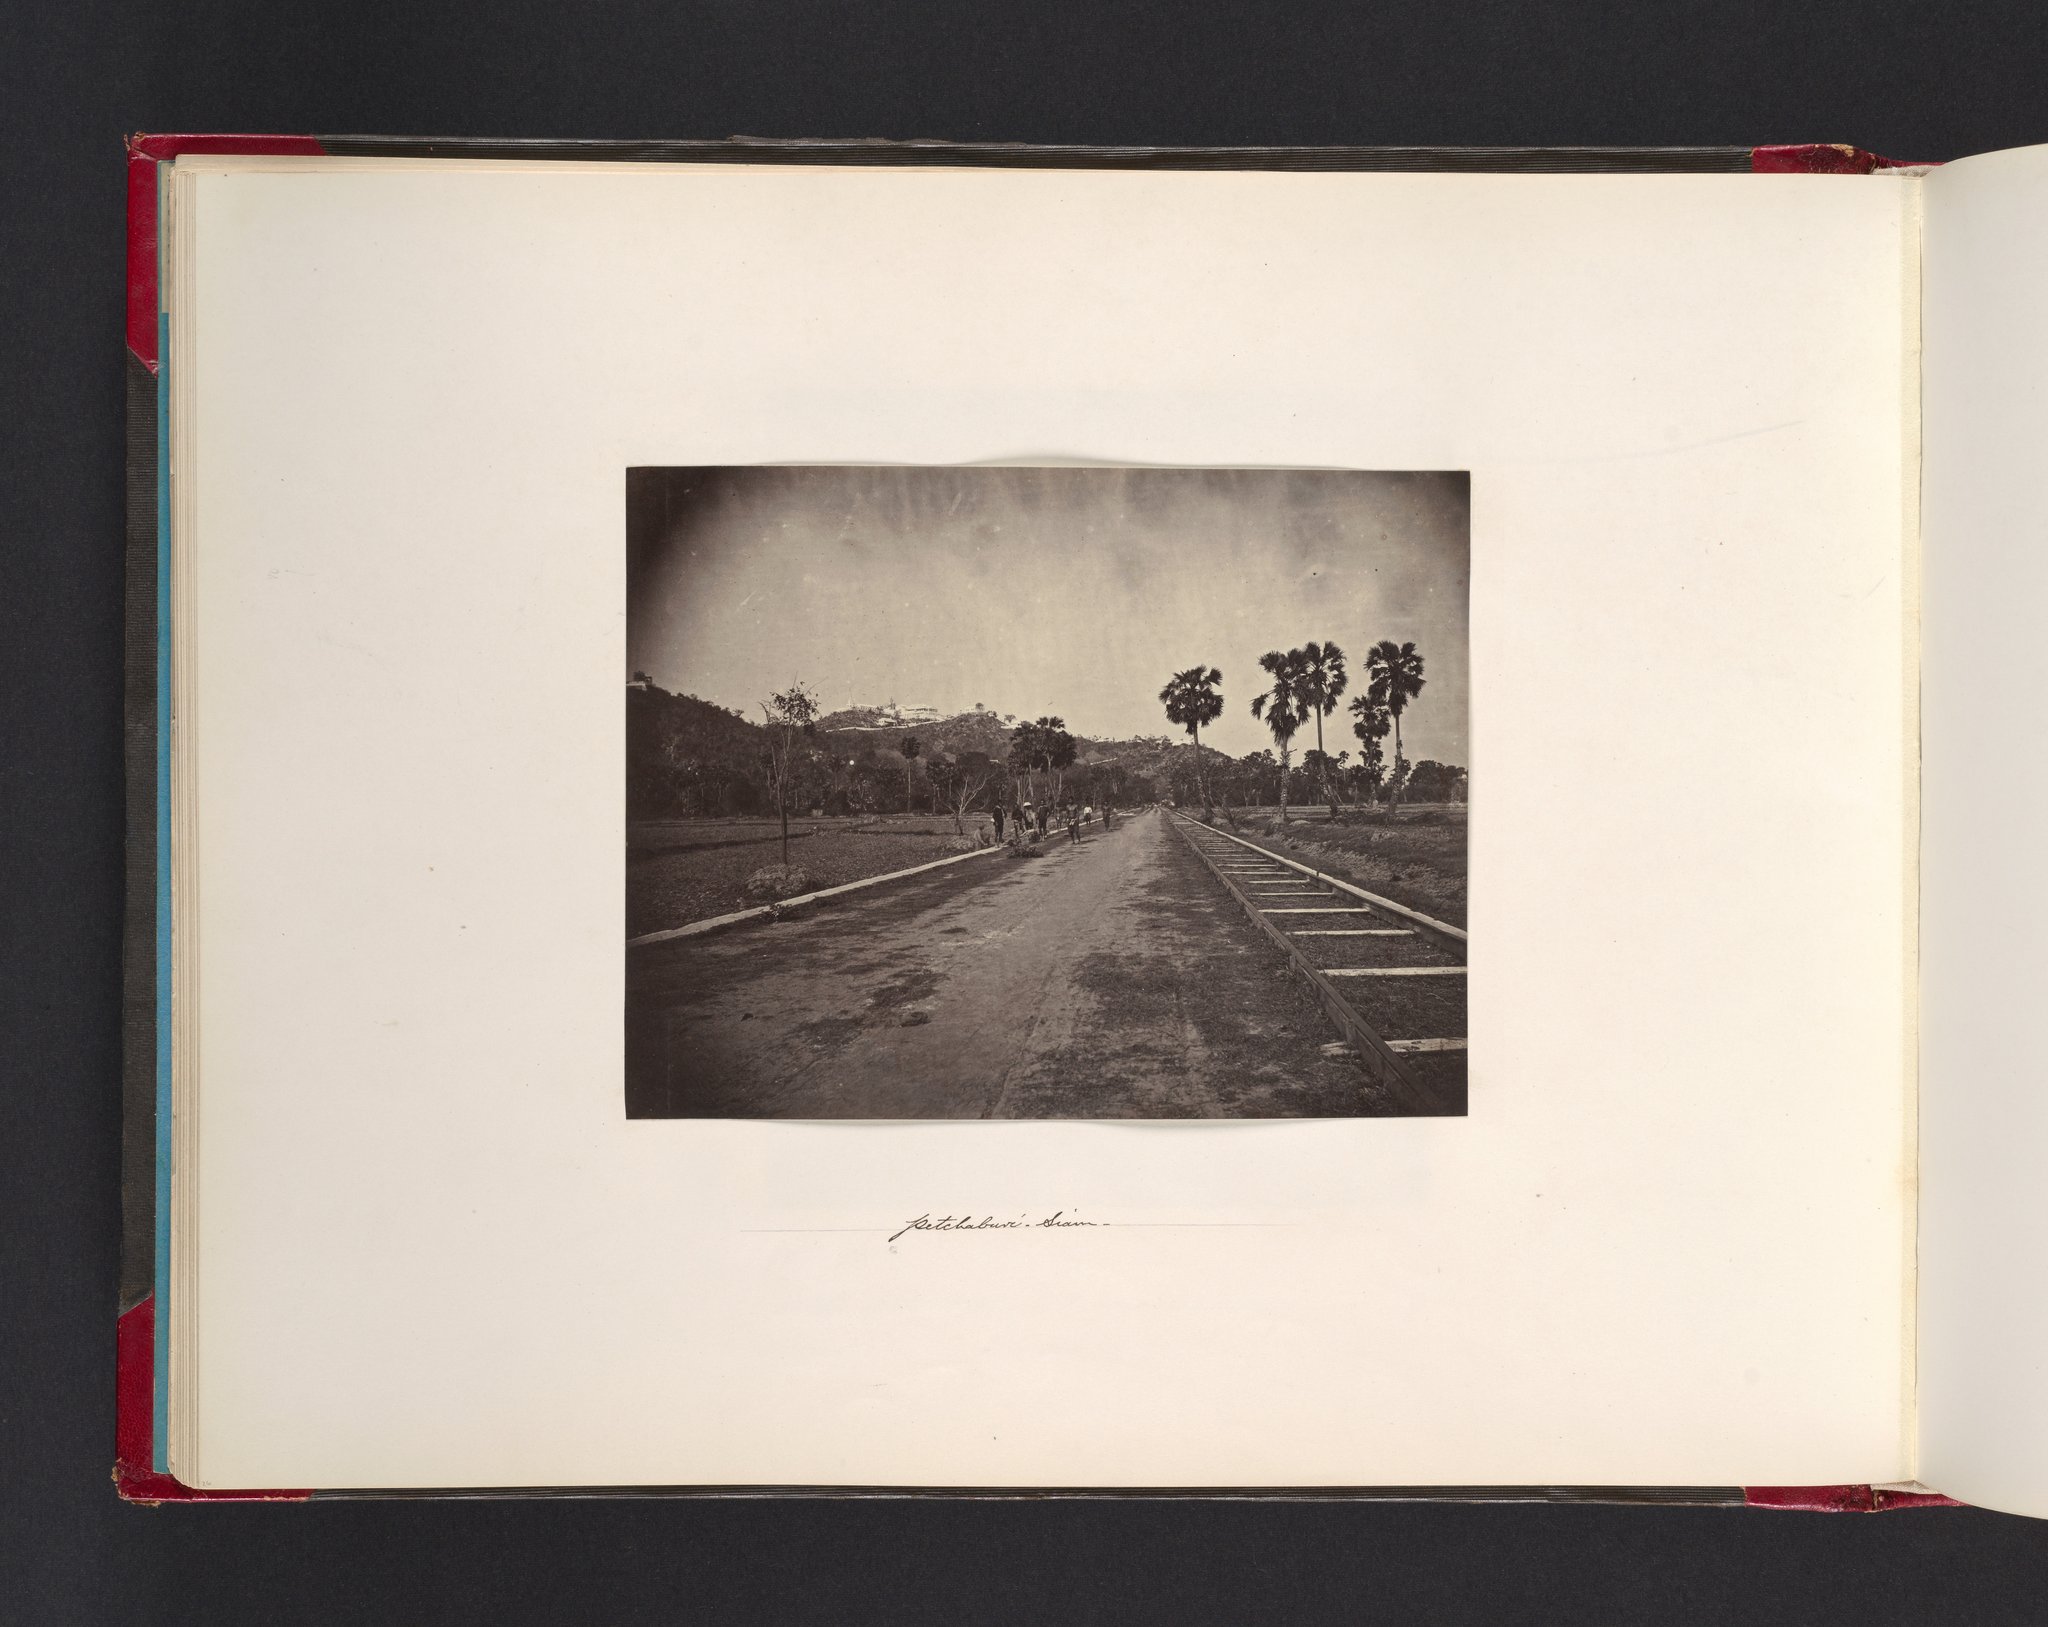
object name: photograph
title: Petchaburi, Siam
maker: john thomson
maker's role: artist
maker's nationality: british, scottish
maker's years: 1837-1921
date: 1865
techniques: albumen silver print, glass negative